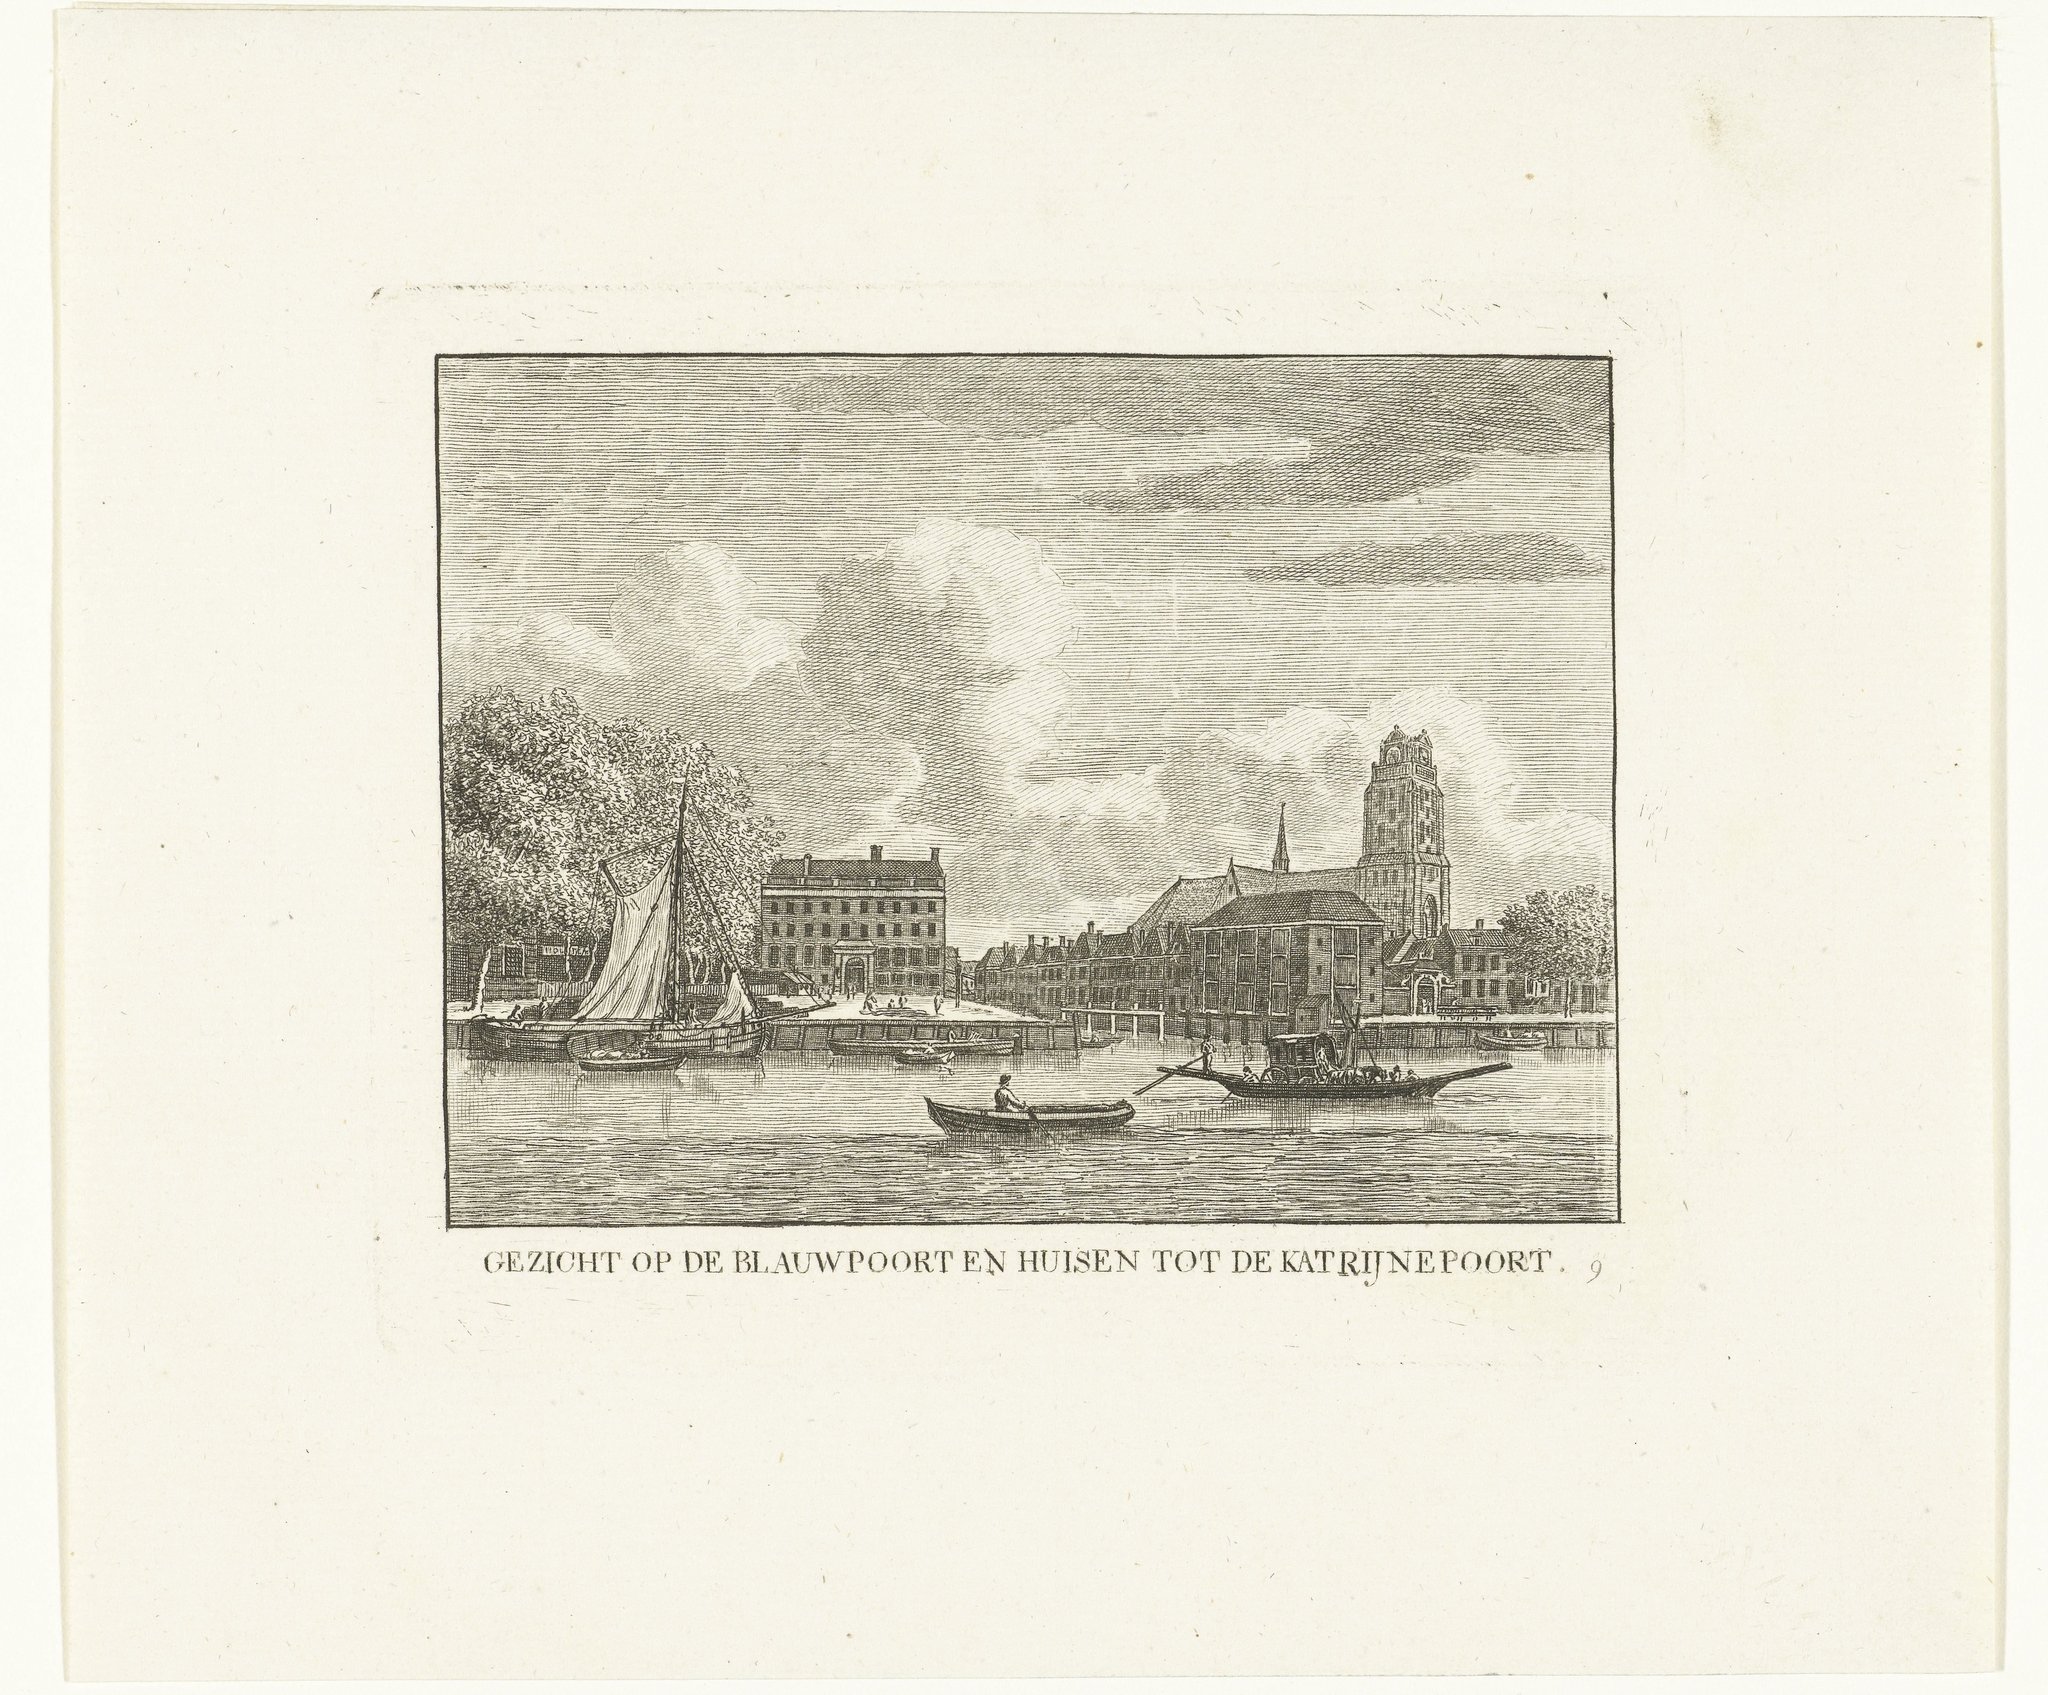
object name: print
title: Gezicht vanaf Merwede op Blauwpoort en Catharijnepoort te Dordrecht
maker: carel frederik bendorp (i)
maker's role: print maker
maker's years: 1736-1814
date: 1803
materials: paper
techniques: etching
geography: dordrecht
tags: prospect of city, town panorama, silhouette of city, dordrecht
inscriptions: collector's mark: Lugt 2228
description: Prent uit: XII Gezichtjes der Stadt Dordrecht. Langs de water zijde. Getekent en int koper gebracht door K.F. Bendorp, 1803